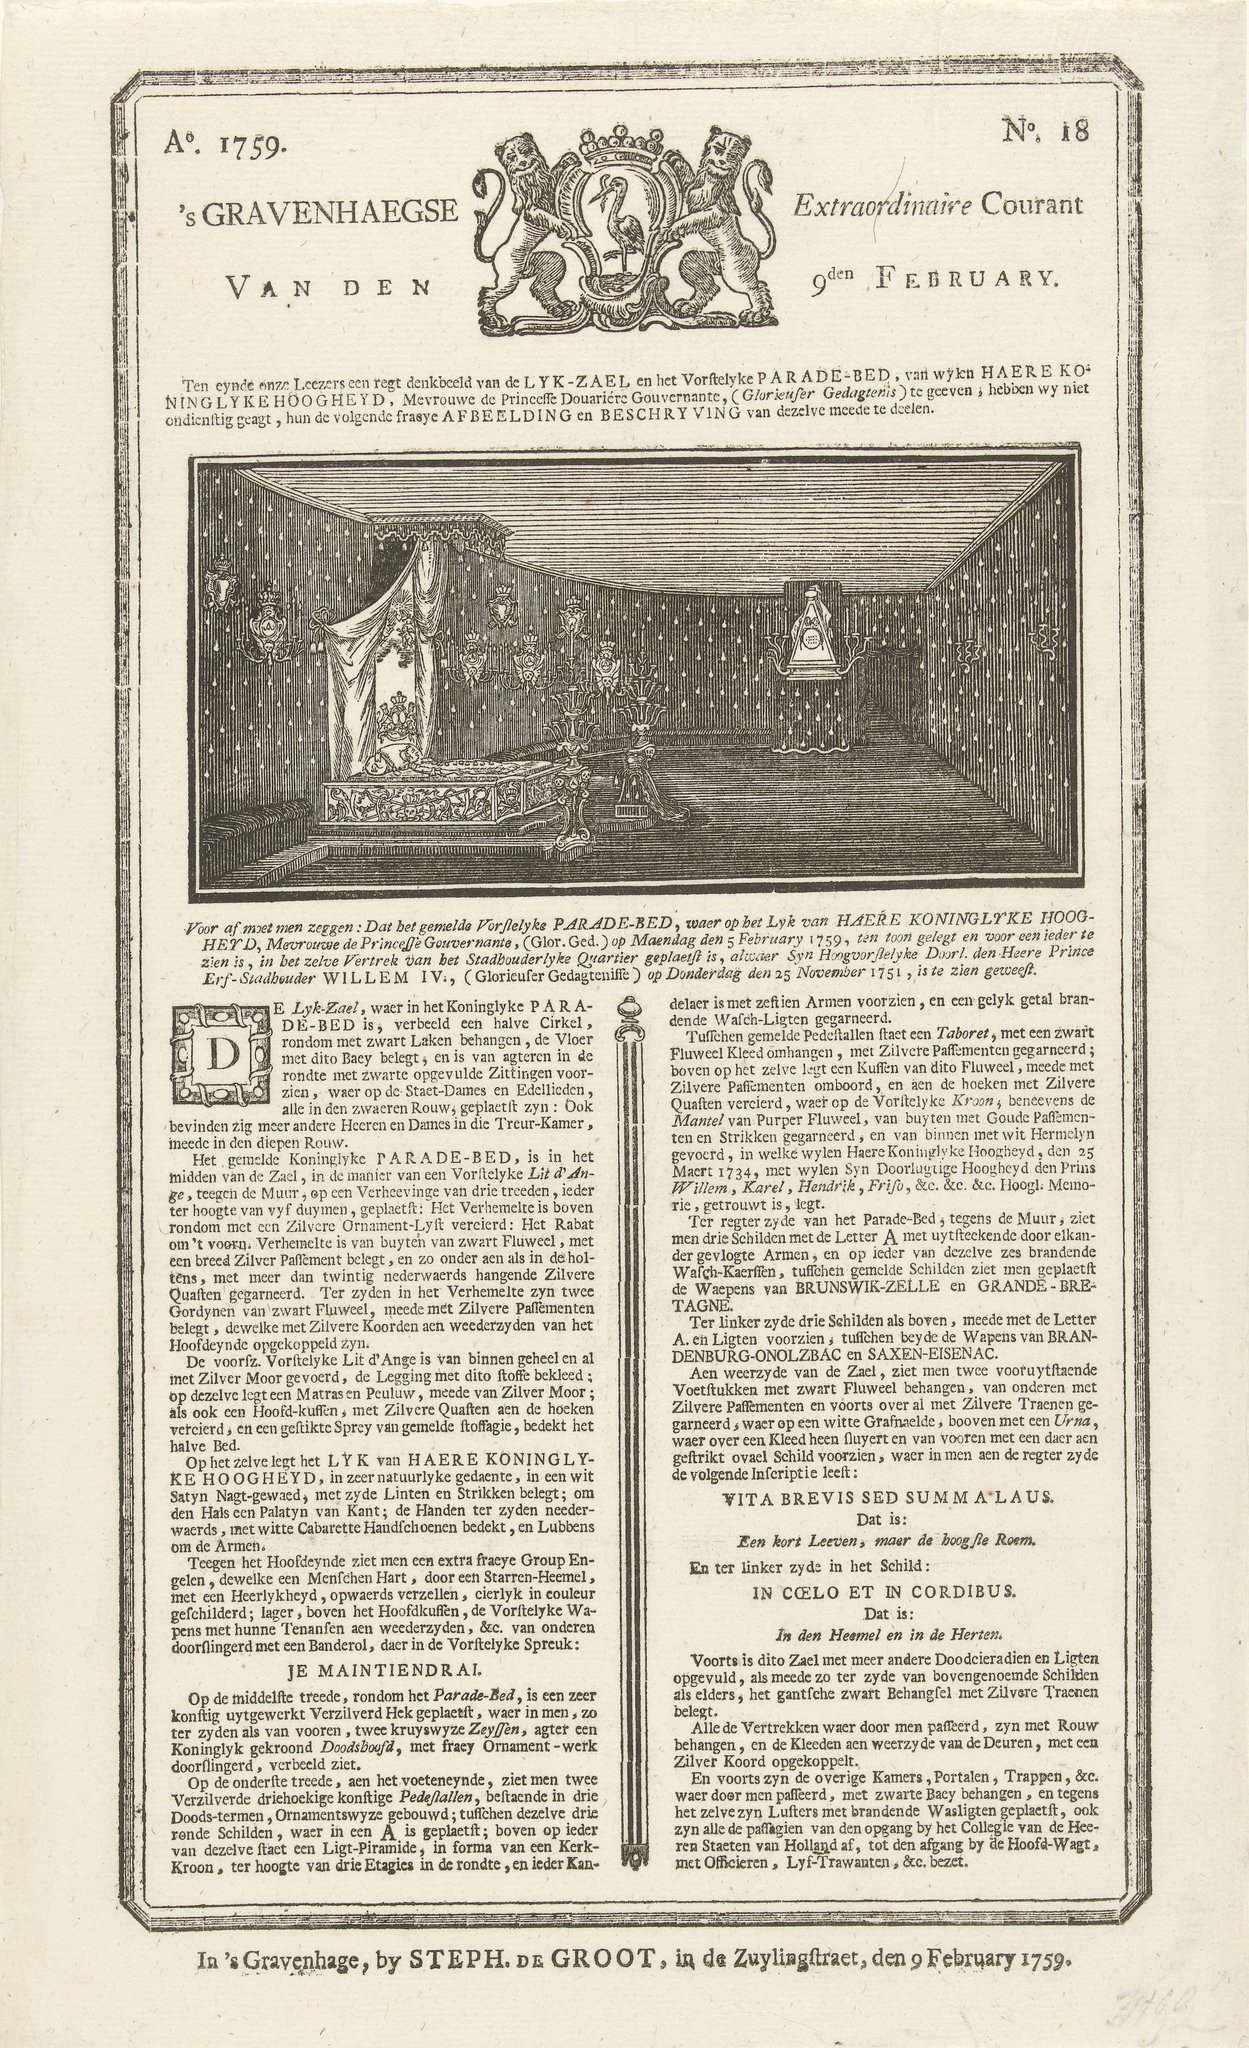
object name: newspaper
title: 's Gravenhaegse Extraordinaire Courant van den 9den February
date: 1759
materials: paper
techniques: letterpress printing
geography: the hague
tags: anna van hannover, lying in state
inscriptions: collector's mark: Lugt 2228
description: Extra editie van de 's Gravenhaegse Courant van 9 februari 1759 No. 18. Voorstelling van de praalzaal met het paradebed waarop op 5 februari het opgebaarde lichaam van prinses Anna is gelegd. Op het blad onder de plaat een beschrijving van de zaal in 2 kolommen. Bovenaan een vignet met het Haagse stadswapen.